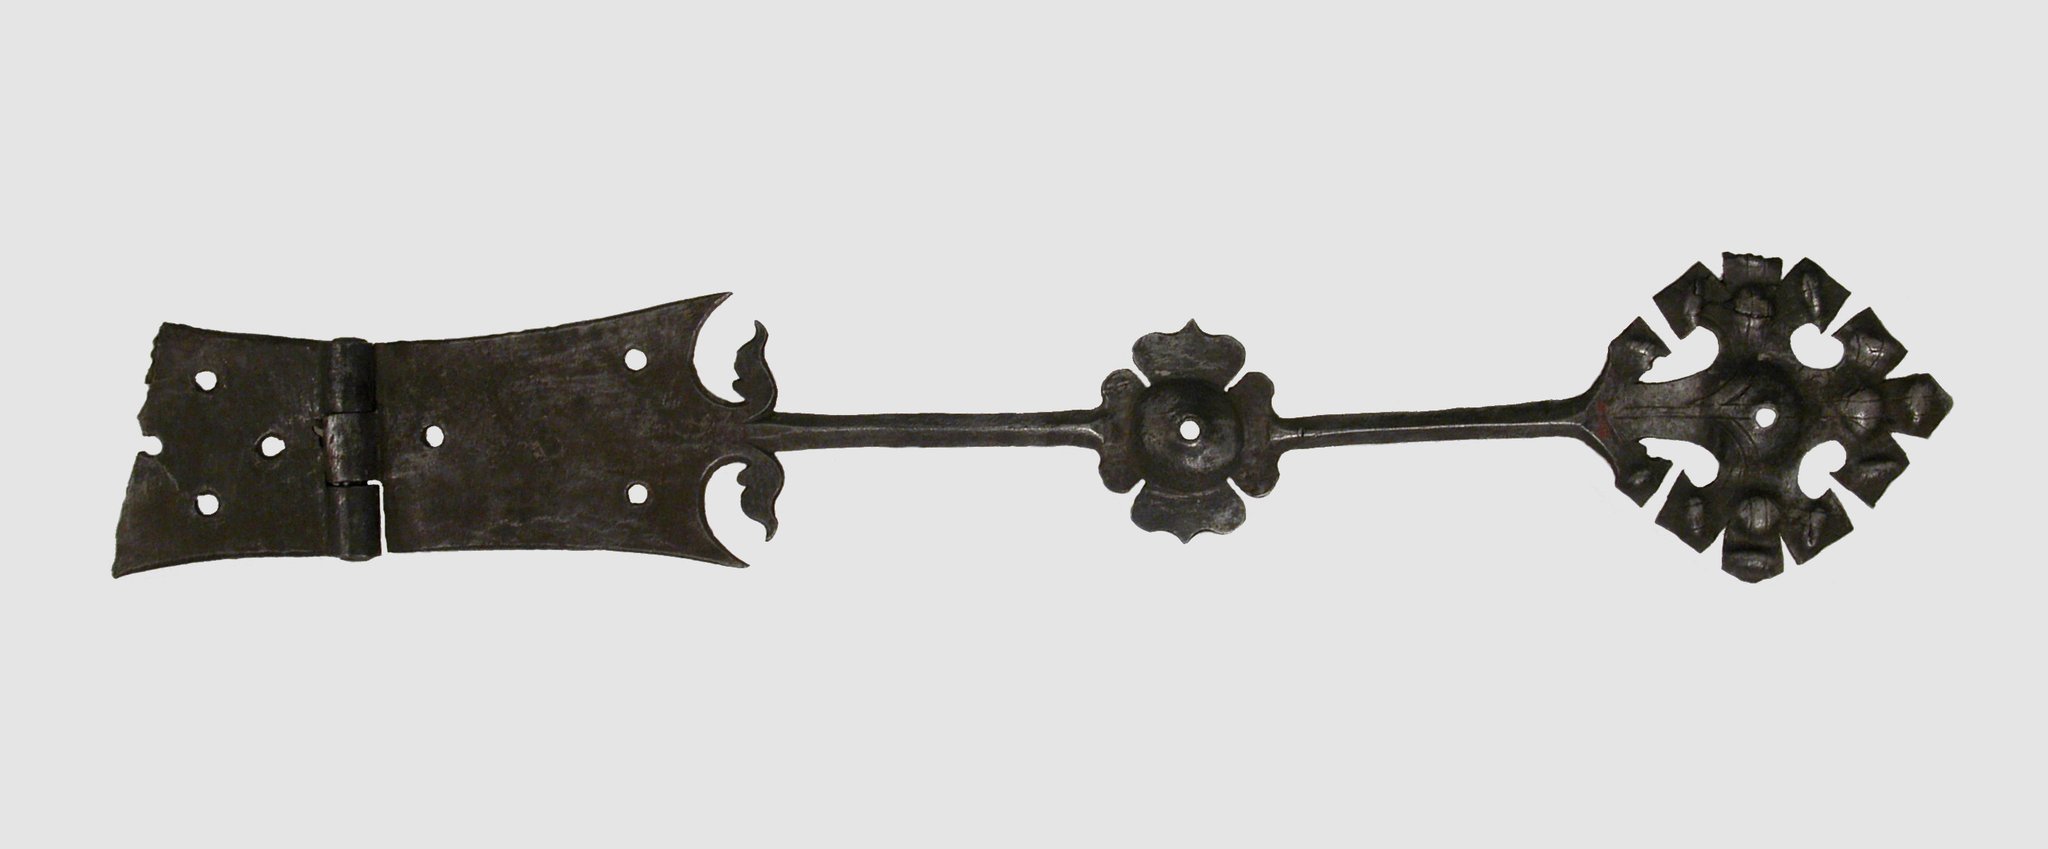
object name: door hinge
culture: german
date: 1401-1500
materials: iron